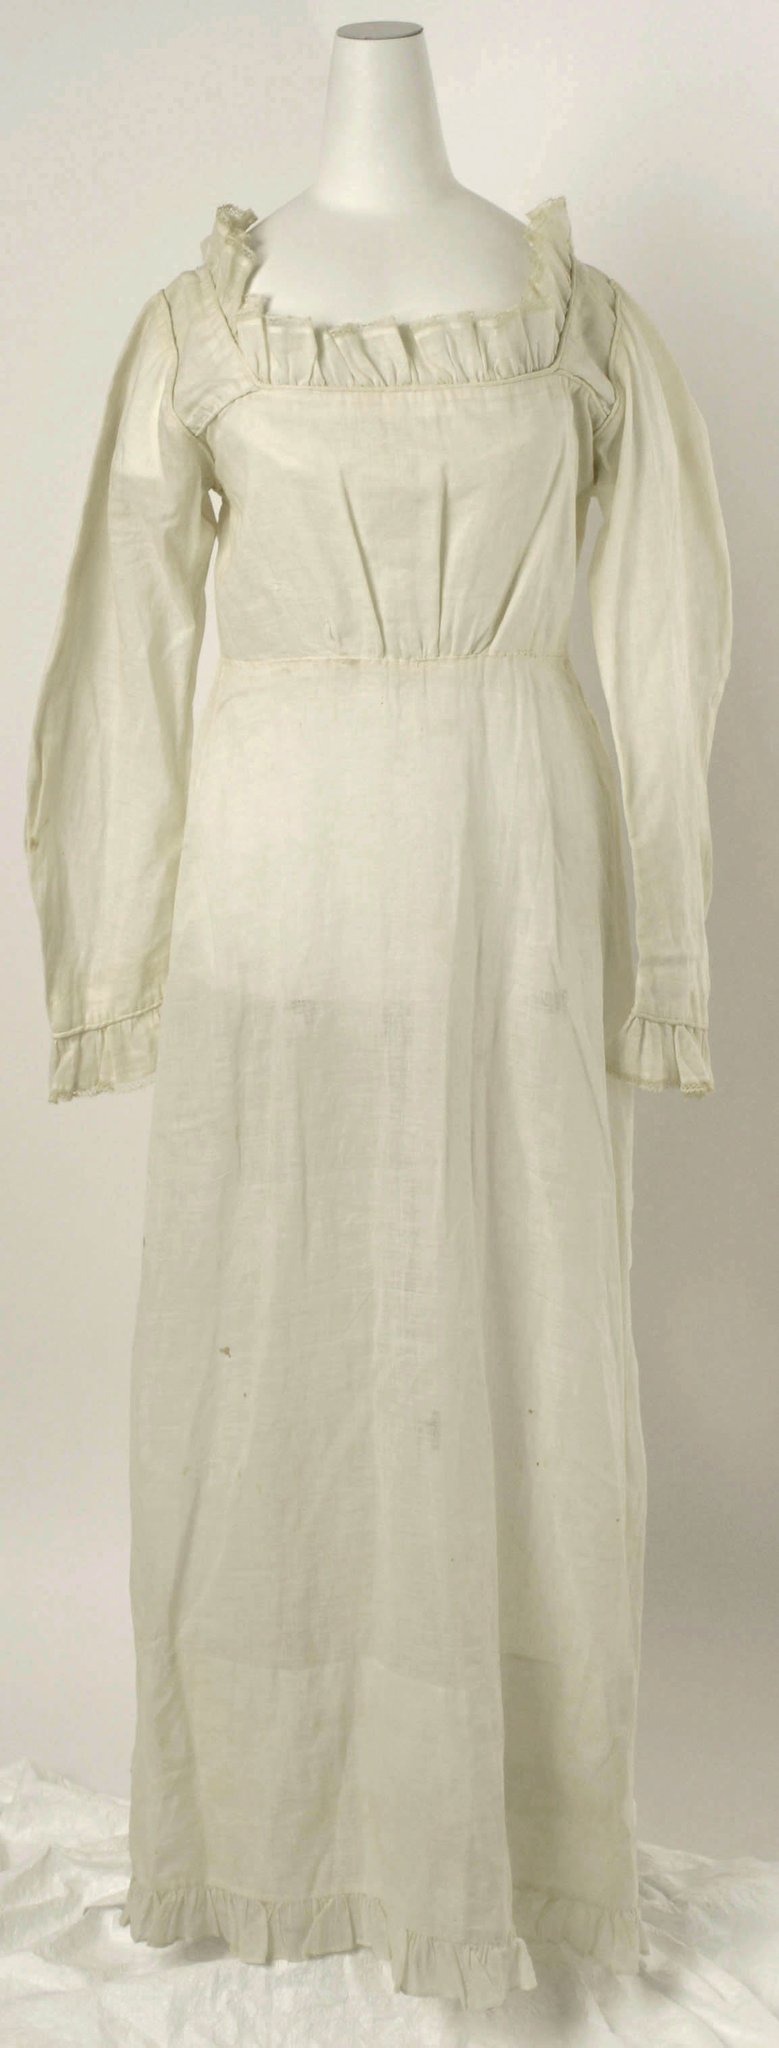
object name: underdress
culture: american or european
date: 1830-1839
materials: cotton